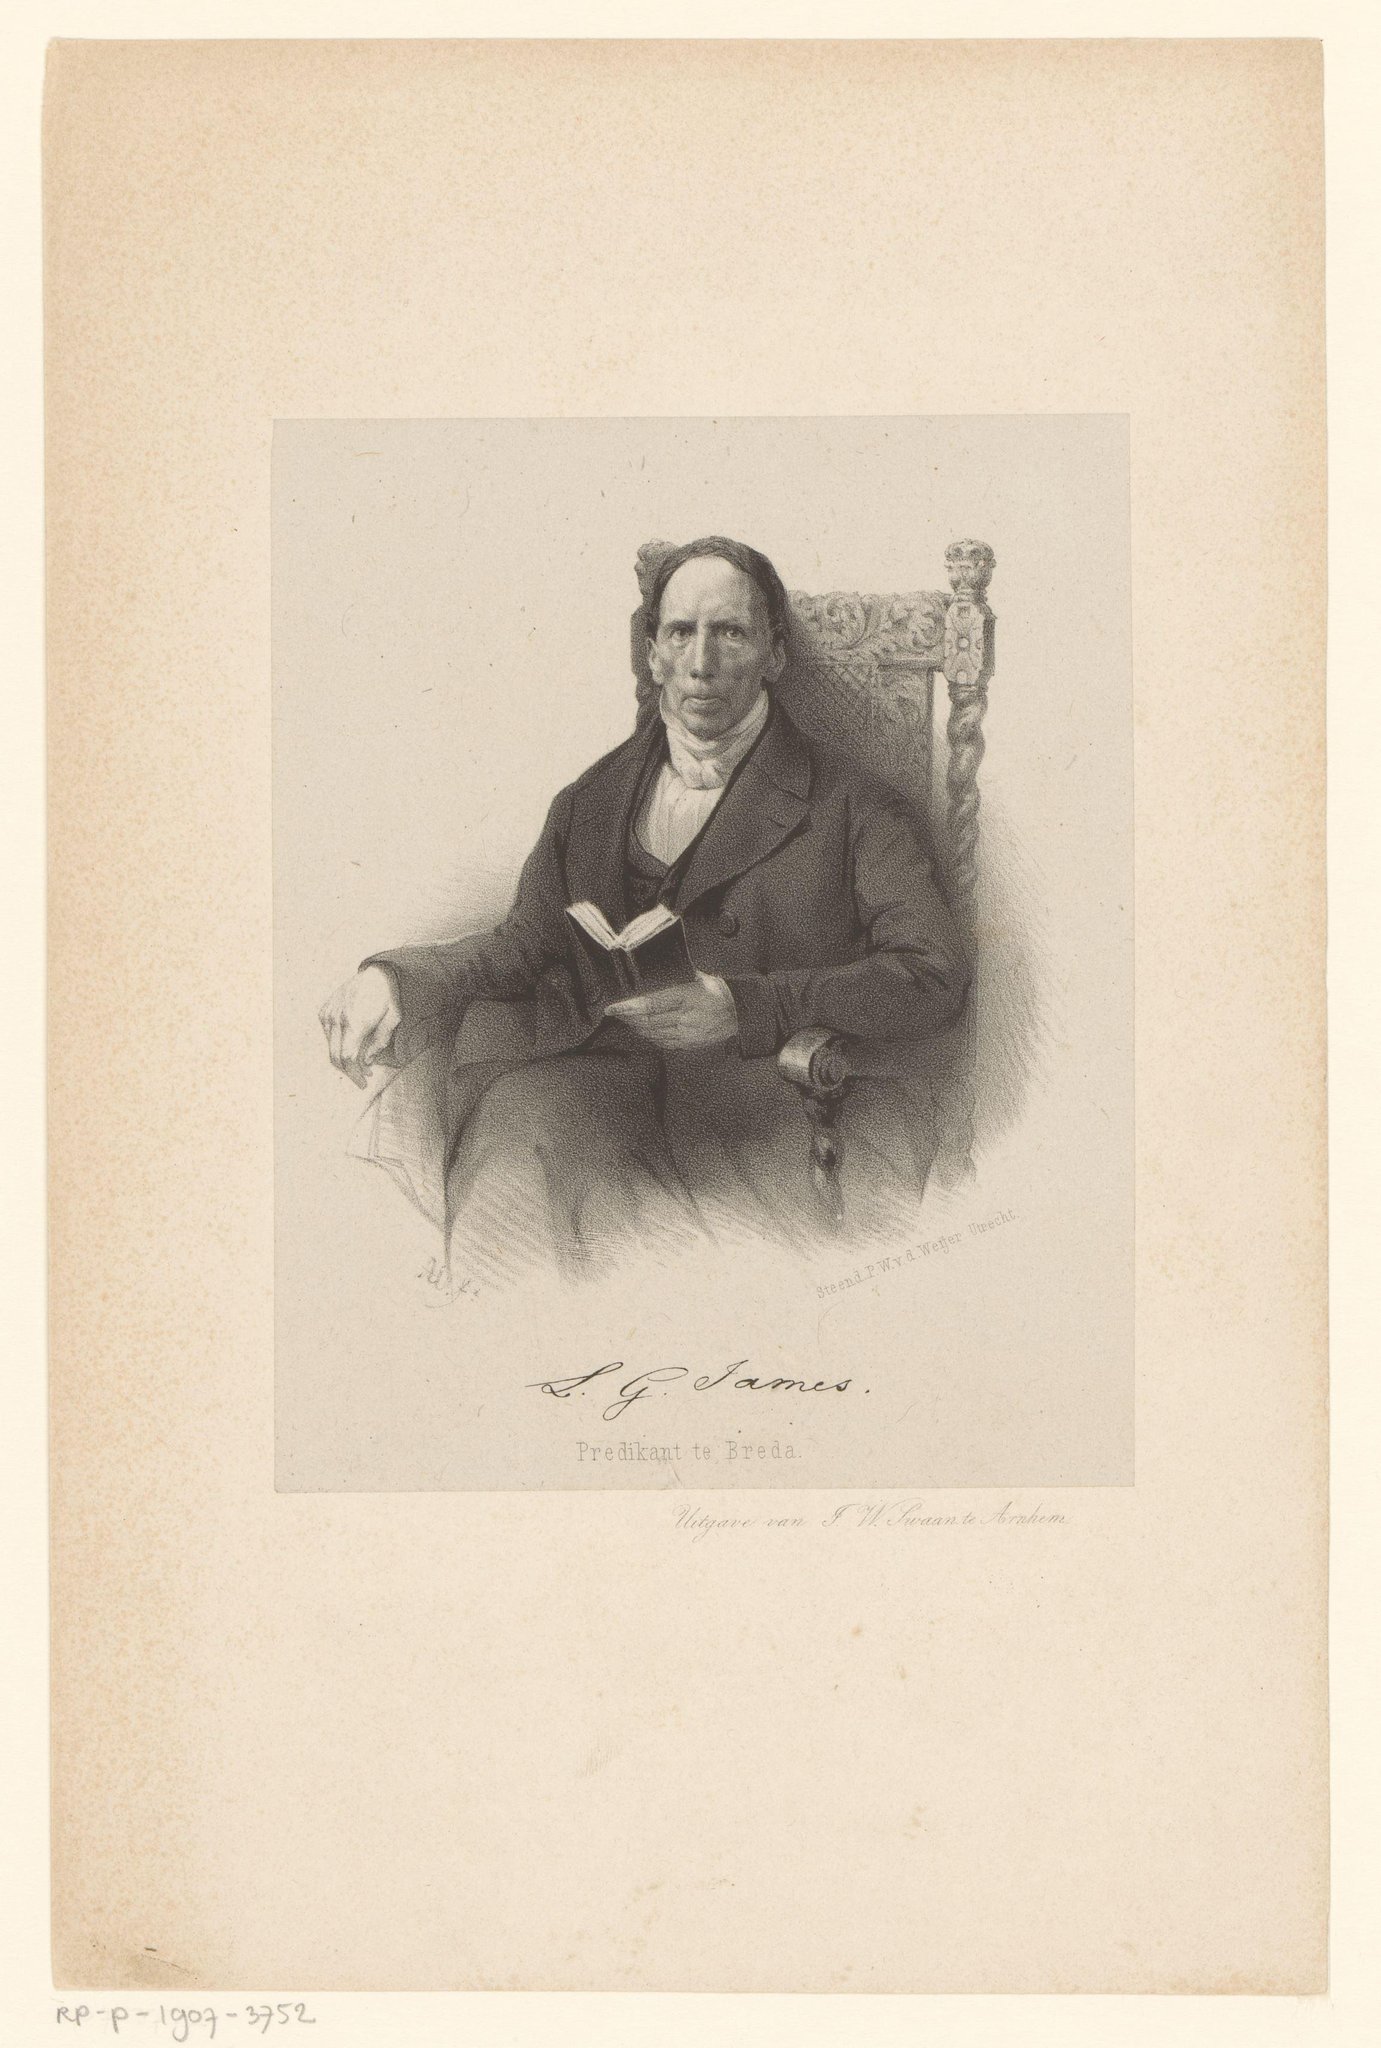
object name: print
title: Portret van Louis Gabriël James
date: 1845-1865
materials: paper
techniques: lithograph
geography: arnhem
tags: historical persons (+ (full) bust portrait)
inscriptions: monogram: ‘AC’, collector's mark: Lugt 2228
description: Onder het portret de signatuur van de geportretteerde.